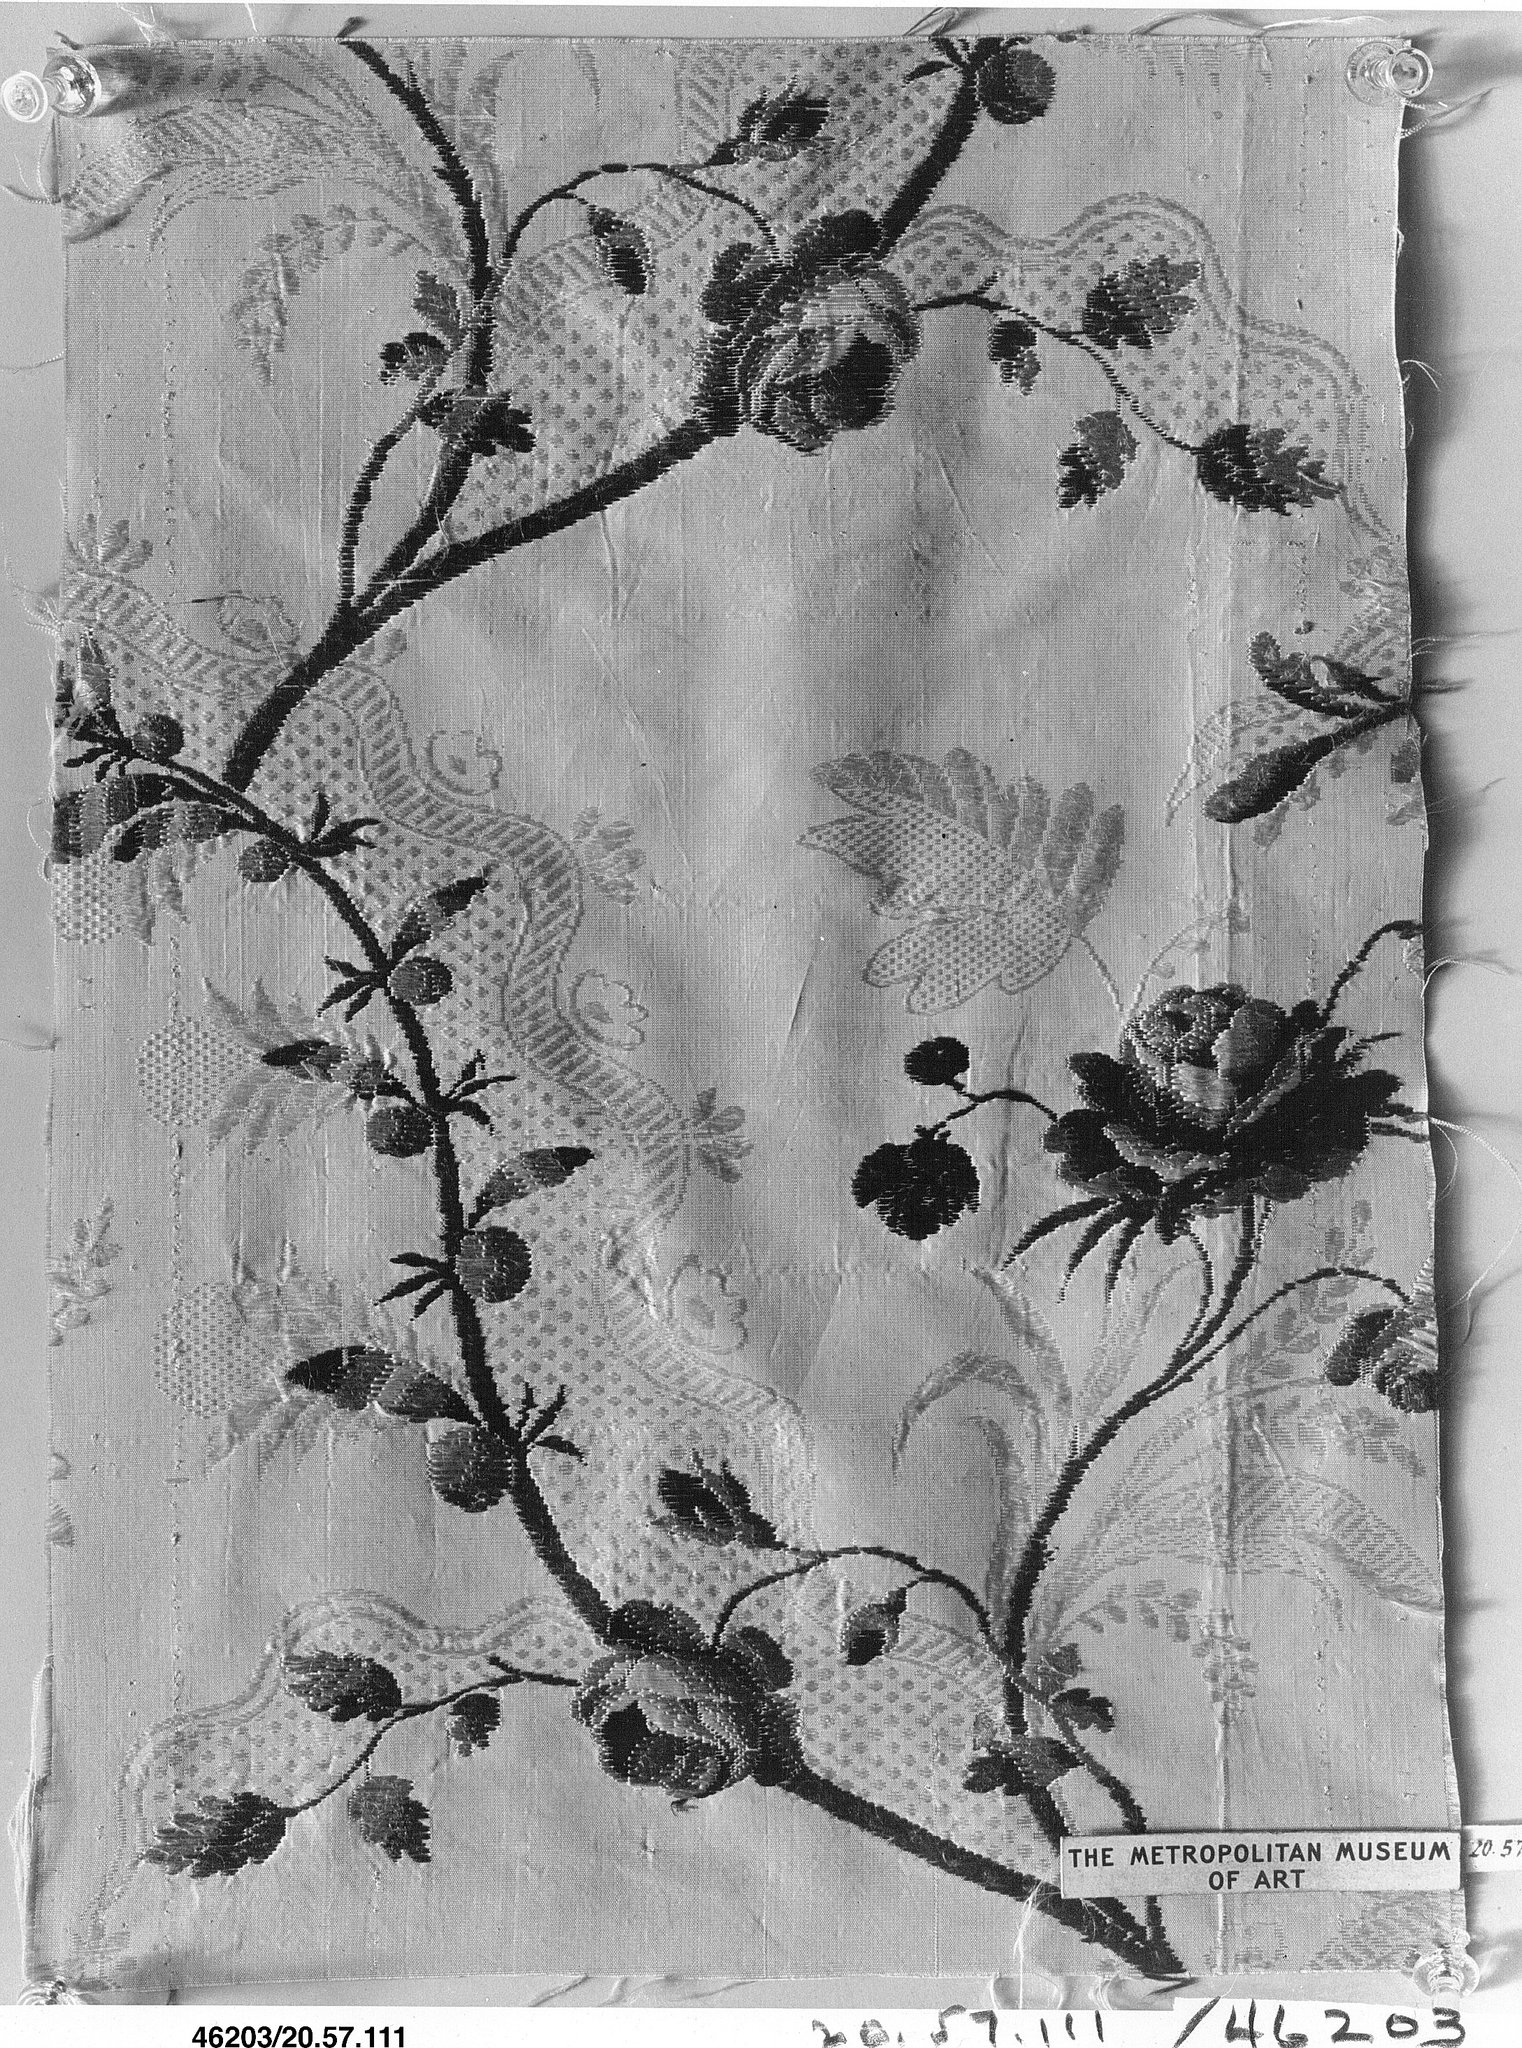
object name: piece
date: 1750-1760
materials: silk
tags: flowers,leaves